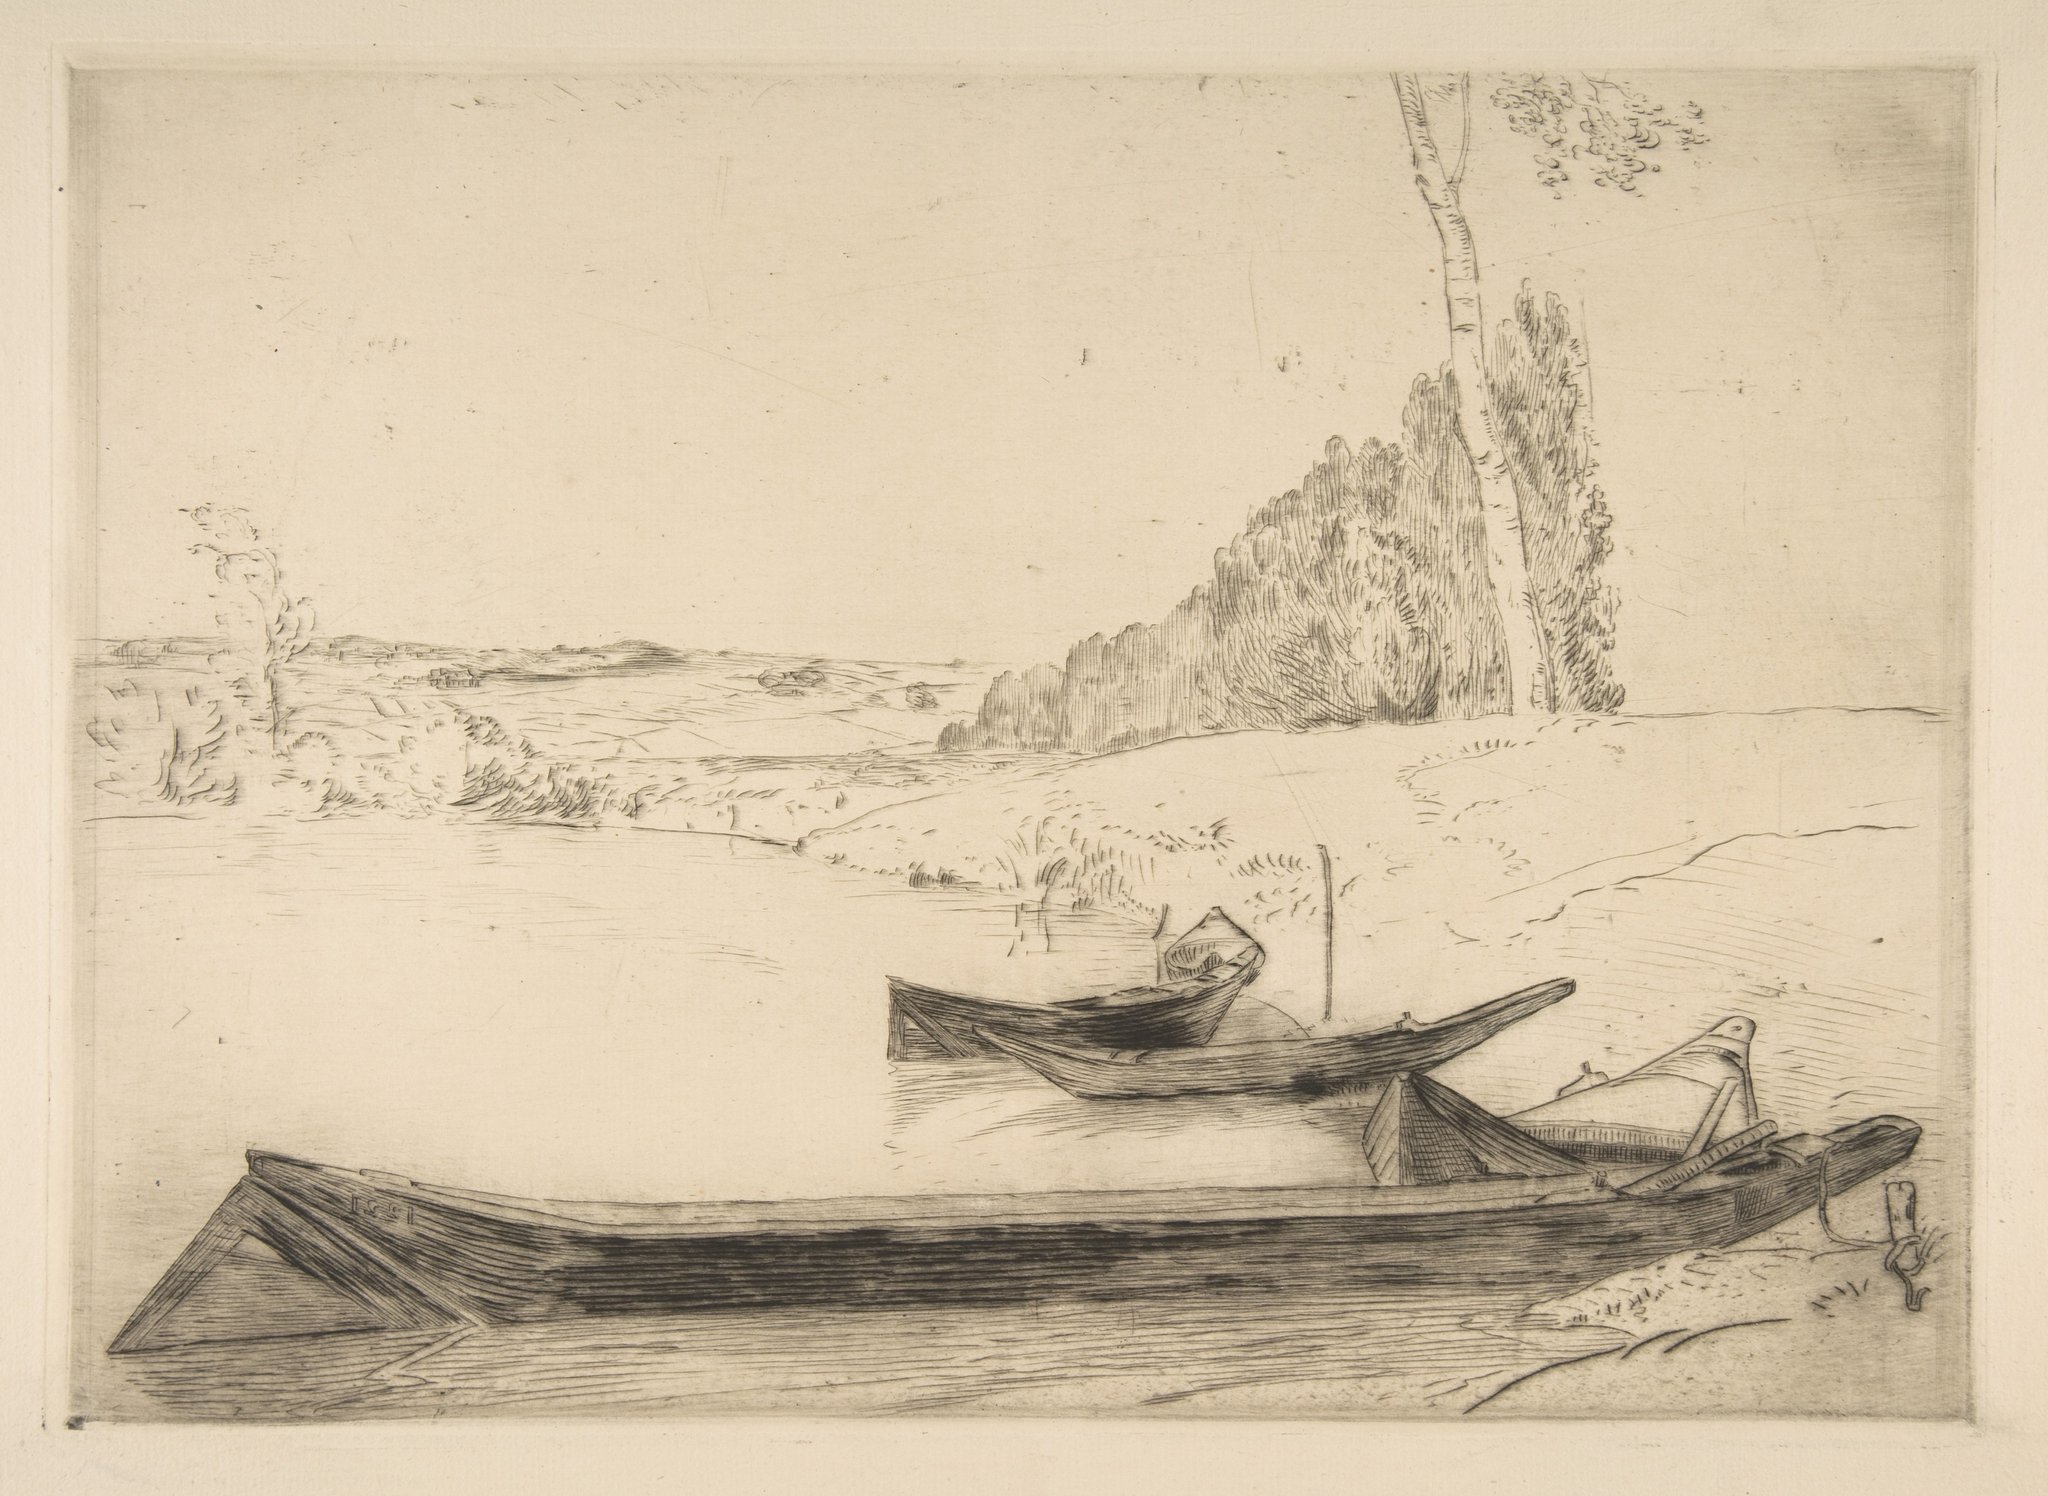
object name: print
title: Bachots au bords de la Seine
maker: félix bracquemond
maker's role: artist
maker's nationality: french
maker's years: 1833-1914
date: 1858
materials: paper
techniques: drypoint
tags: rivers,boats